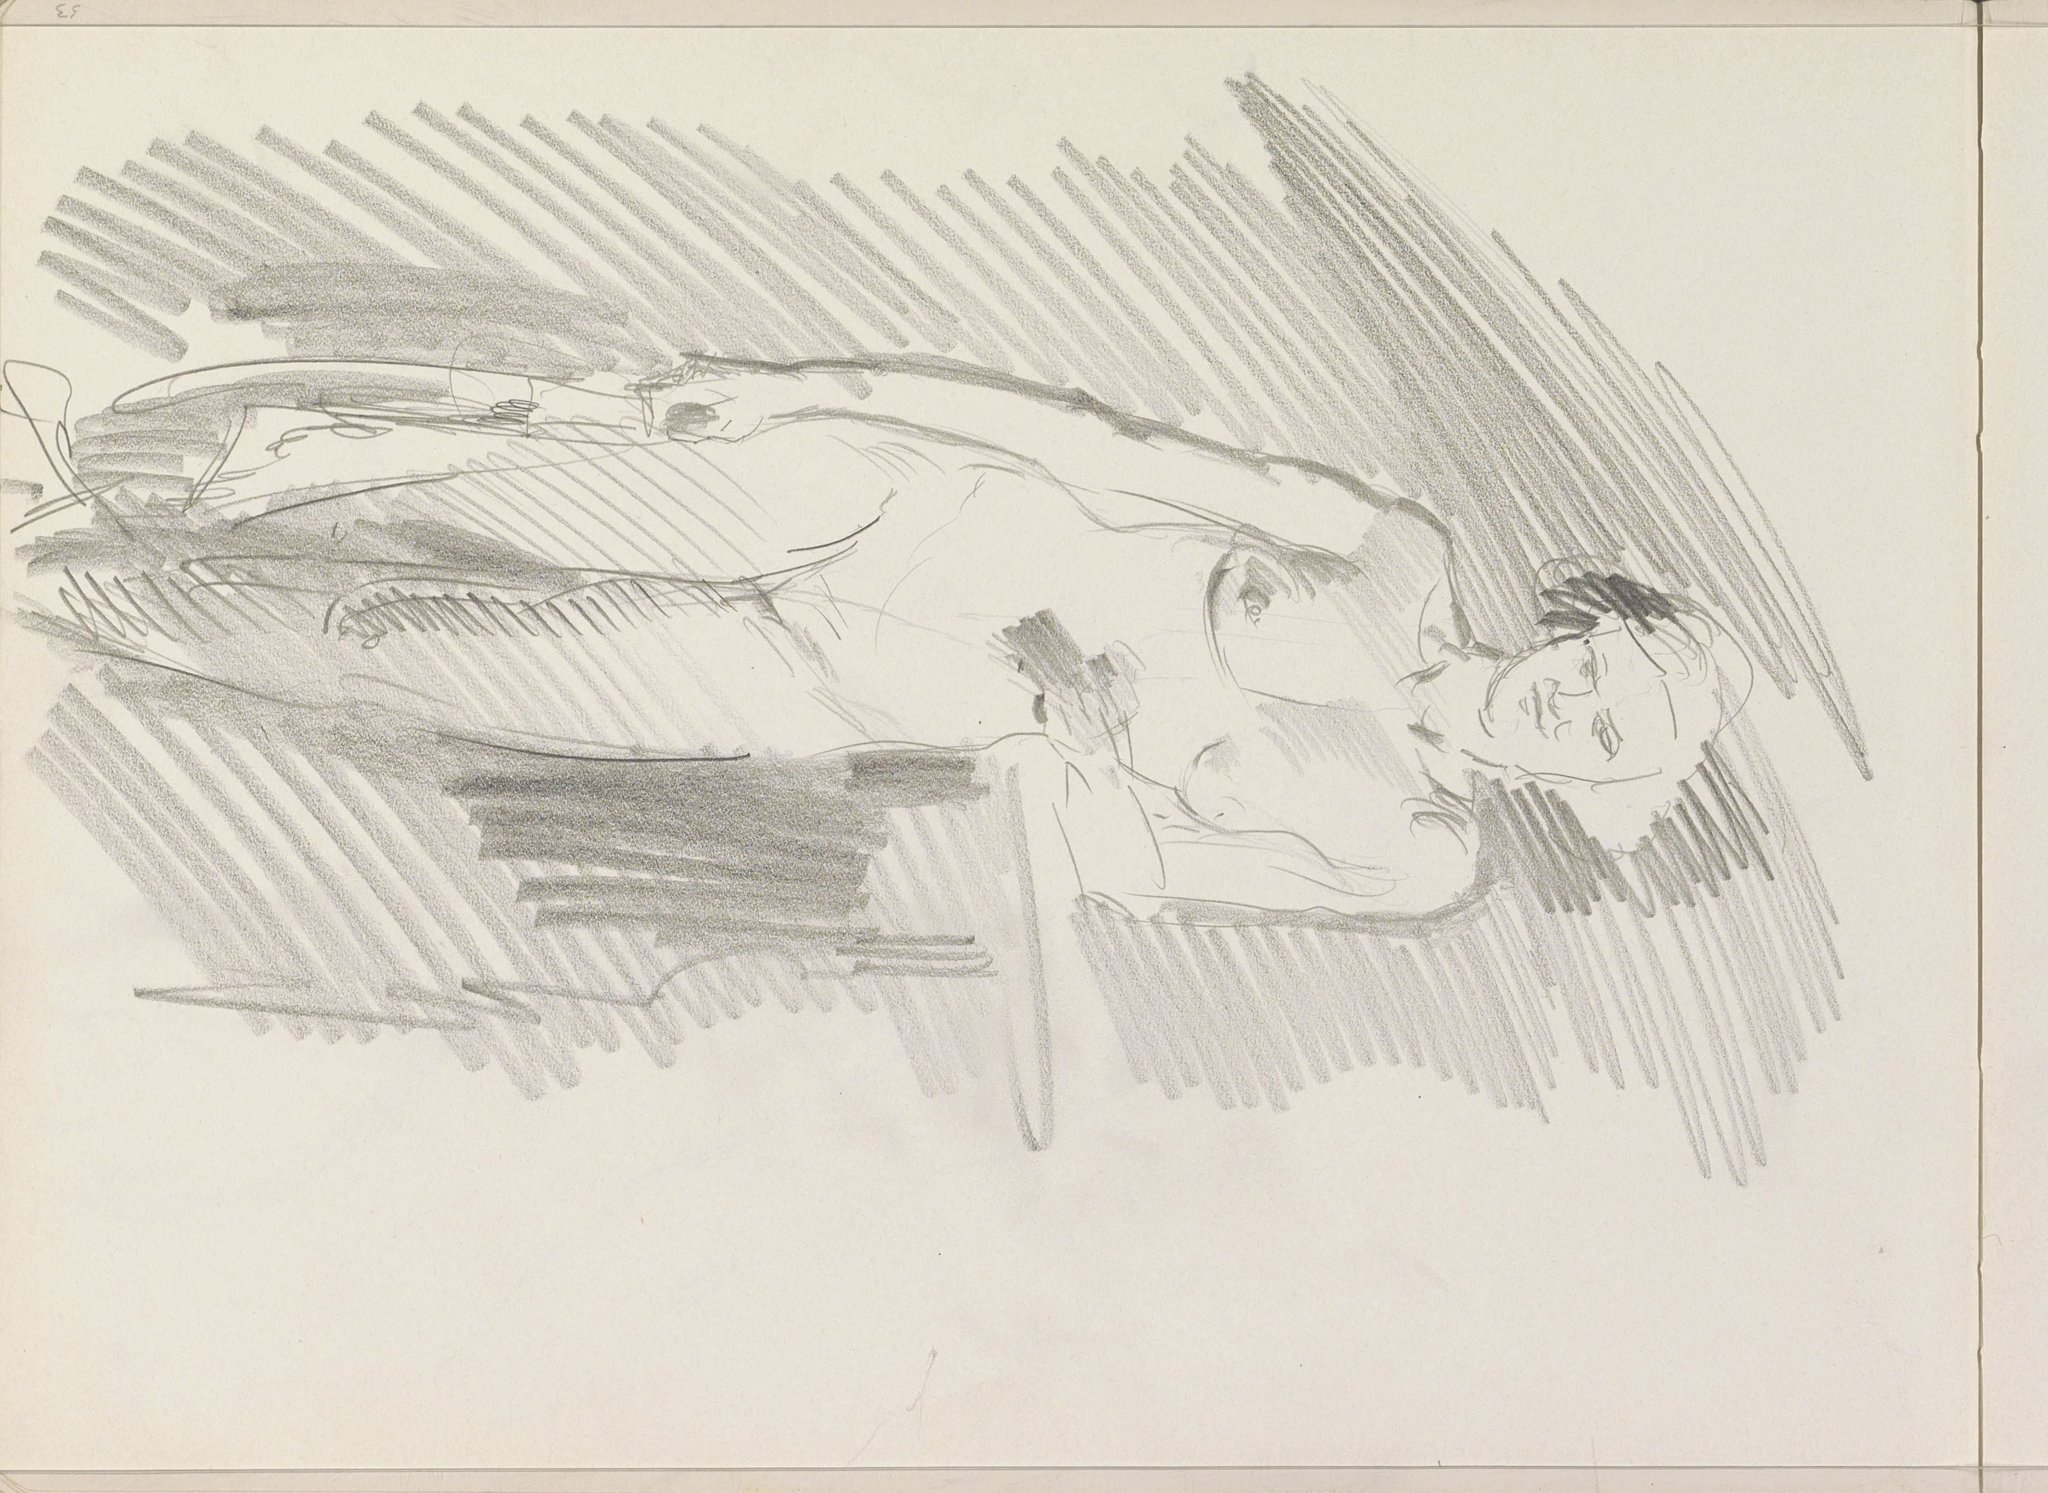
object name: sketchbook leaf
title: Staand vrouwelijk naakt, leunend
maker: isaac israels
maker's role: draughtsman, painter, print maker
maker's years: 1865-1934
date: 1915-1934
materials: paper, pencil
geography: the hague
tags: standing figure - aa - female human figure (+ leaning)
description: In haar rechterhand een doek. Blad 20 verso uit schetsboek III met 36 bladen.